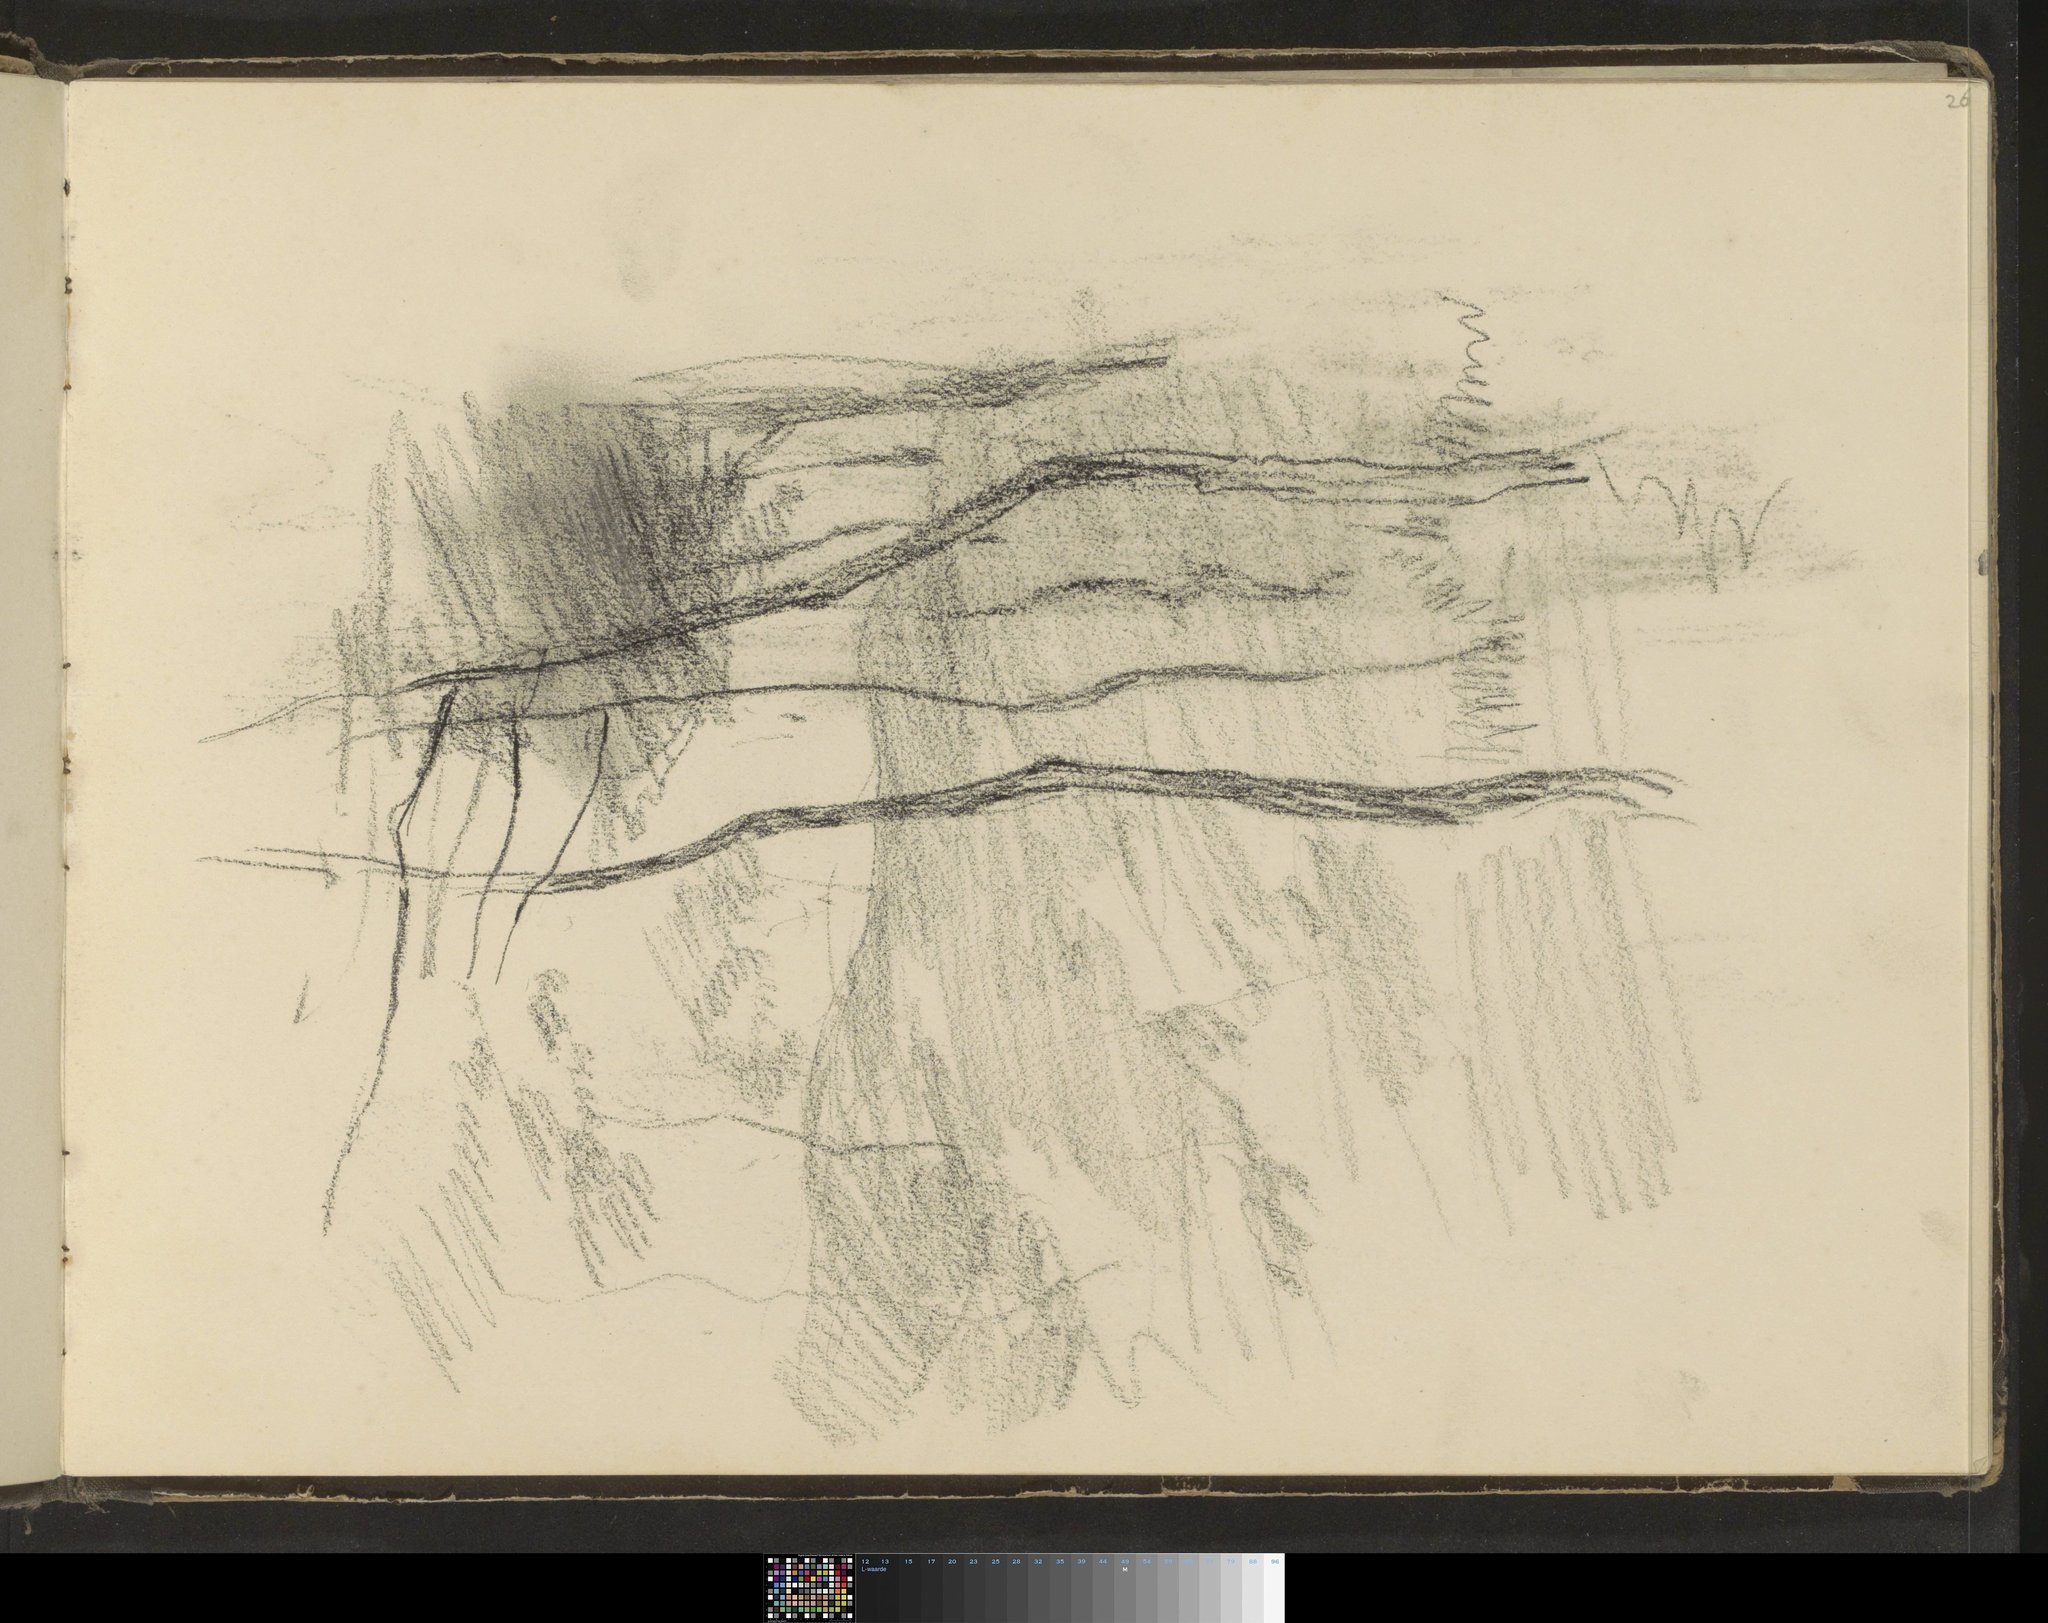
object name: sketchbook leaf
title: Landschap met kale bomen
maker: albert neuhuys (1844-1914)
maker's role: draughtsman, painter, print maker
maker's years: 1844-1914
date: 1854-1914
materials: charcoal, paper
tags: trees, landscapes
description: Blad 26 recto uit een schetsboek met 43 bladen.